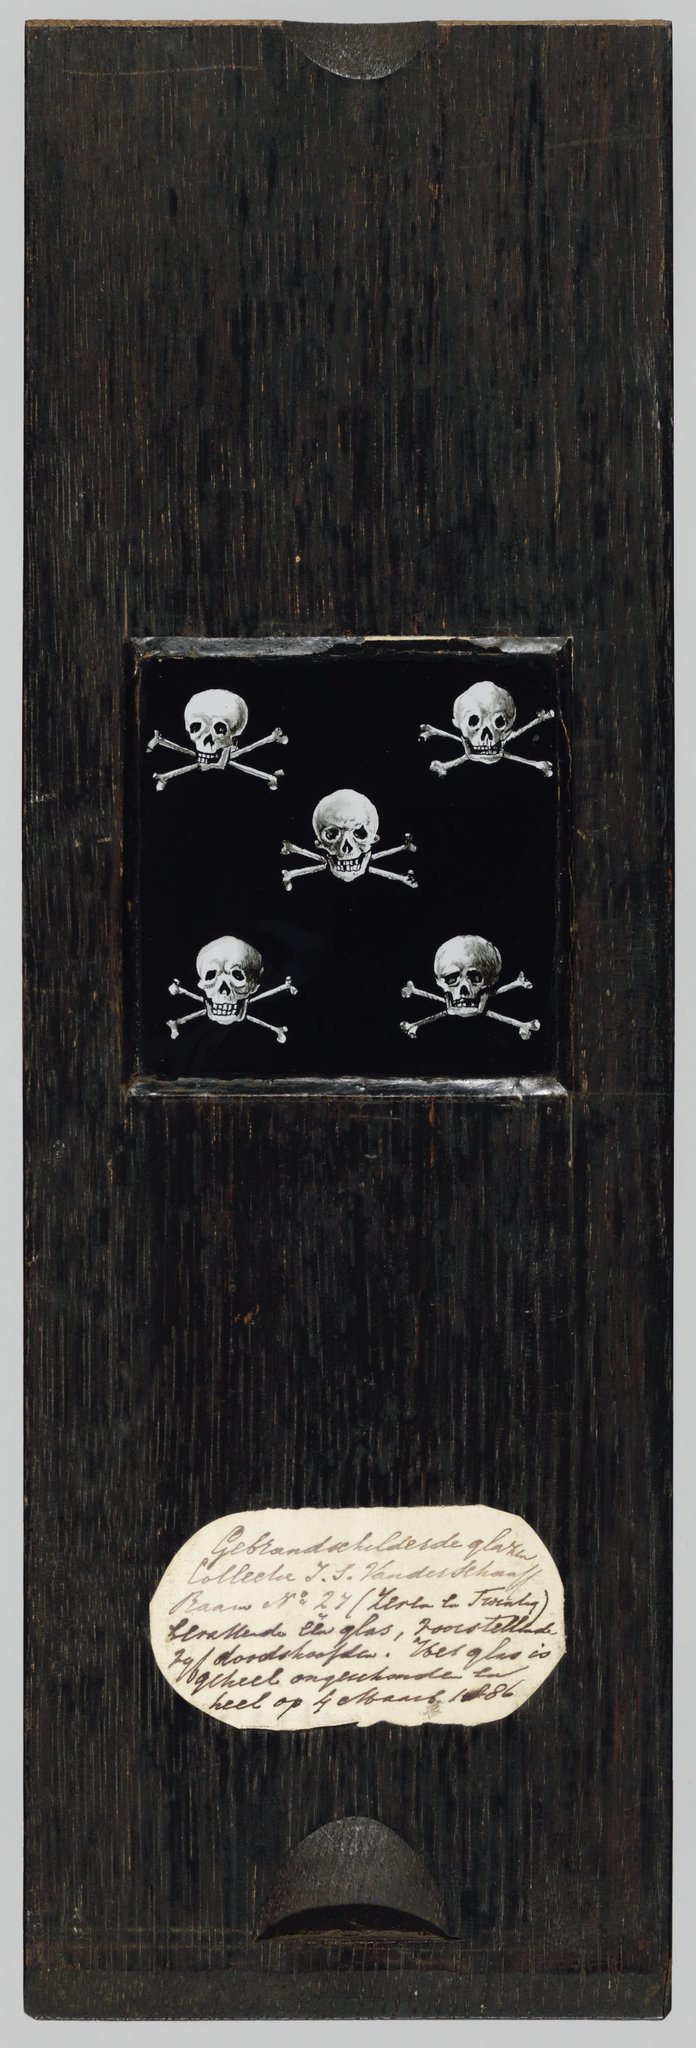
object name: lantern slide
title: Vijf doodskoppen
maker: Anonymous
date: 1793-1830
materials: glass, wood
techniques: painted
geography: netherlands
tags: death's head, skull (symbol of death)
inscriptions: label: ‘'Gebrandschilderde glazen. Collectie J. I. Van der Schaaff Baarn. Nr. 27 (zeven en twintig) bevattende één glas, voorstellende vijf doodskoppen. Het glas is geheel ongeschonden en heel op 4 maart 1886.'’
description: Glasplaat in houten vatting. Vijf doodskoppen in een kruis gerangschikt als op een speelkaart. De achtergrond is zwart.